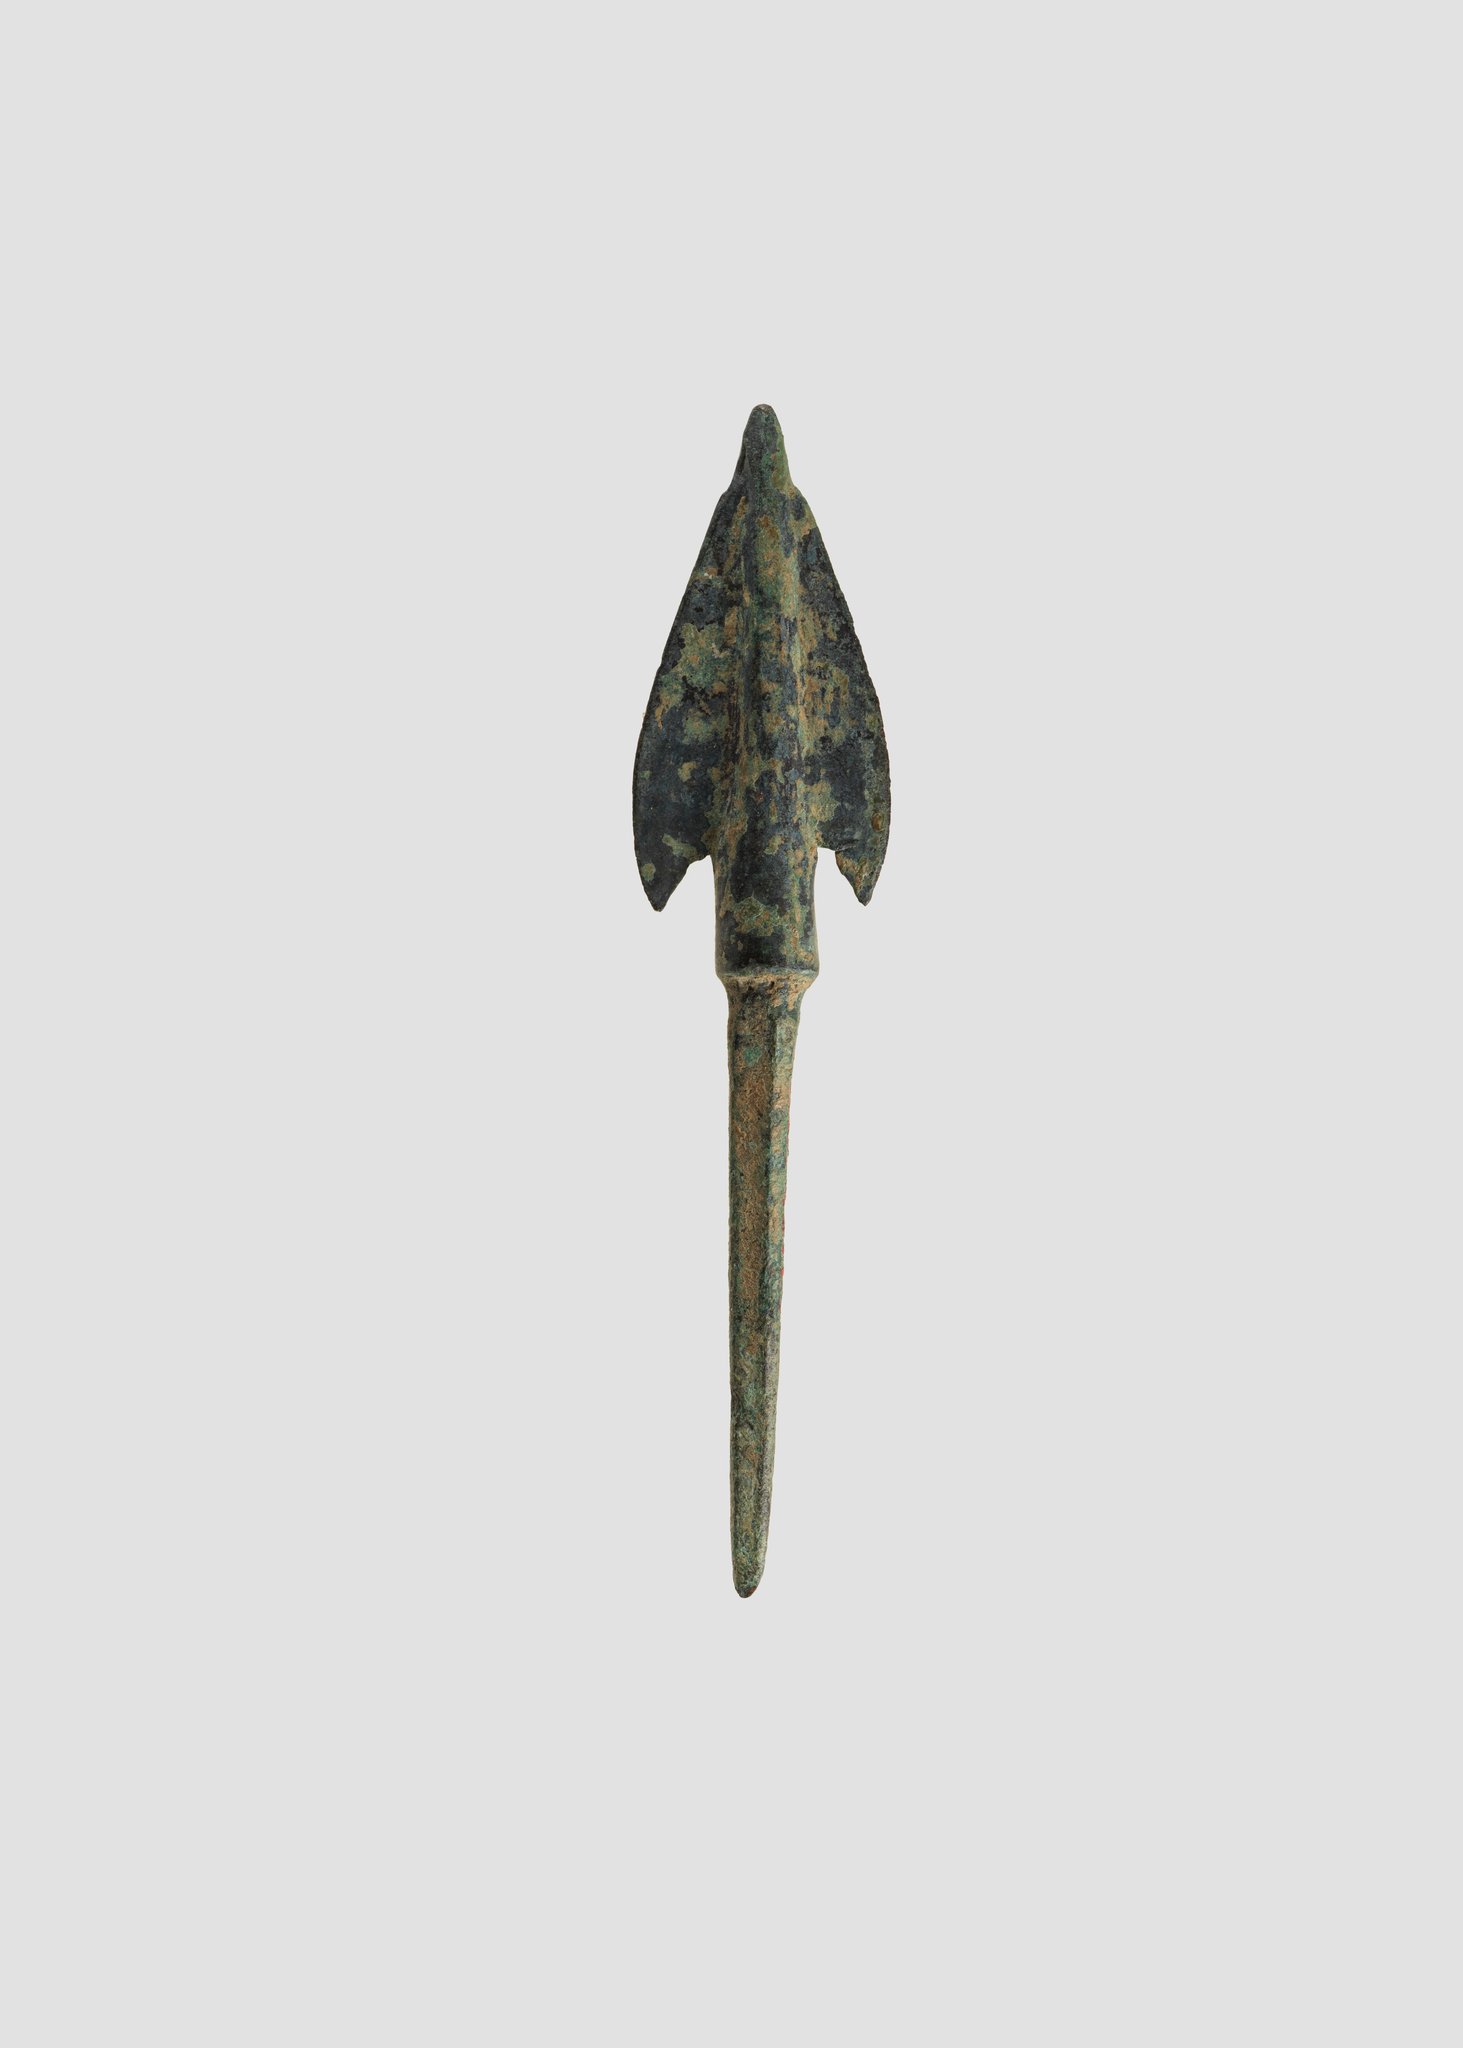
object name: arrowhead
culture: iranian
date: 2000-1 BCE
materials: bronze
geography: iran